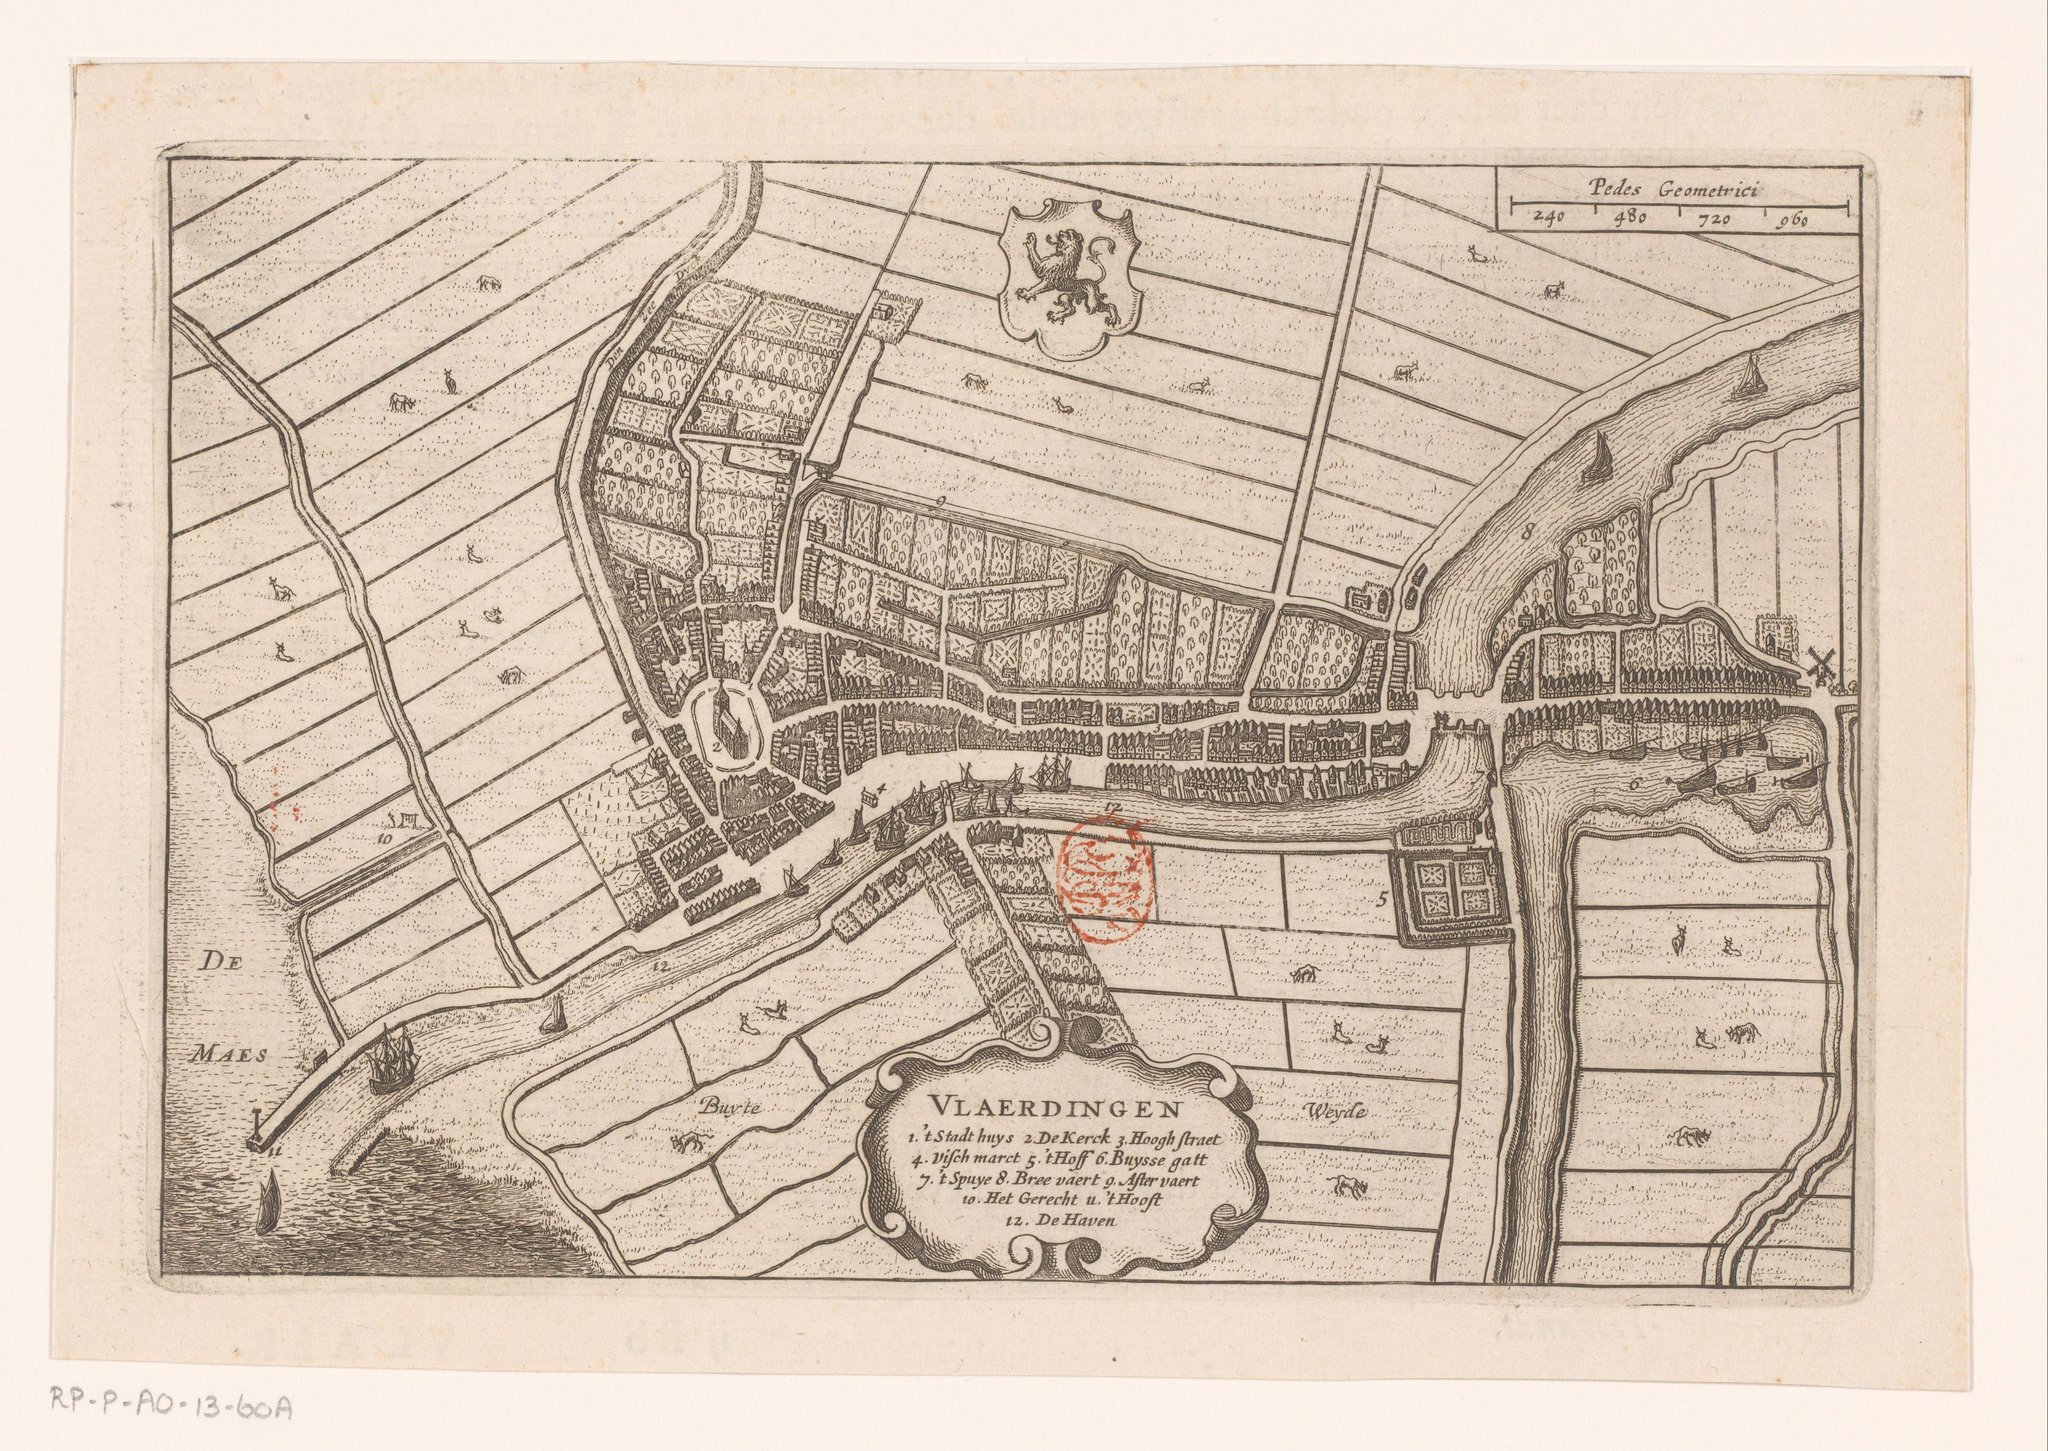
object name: print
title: Plattegrond van Vlaardingen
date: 1632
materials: paper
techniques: engraving, etching, letterpress printing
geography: amsterdam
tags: coat of arms (as symbol of the state, etc.) (+ city; municipal), maps of cities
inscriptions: collector's mark: Lugt 195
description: Prent gebruikt in: Blaeu, Johannes Willemszoon. Toonneel der steden van de Vereenighde Nederlanden. 2 delen. Amsterdam: Johannes Willemszoon Blaeu, 1652, dl. 1. Prent voor het eerst ook gebruikt in: Boxhorn, Marcus Zuerius van. Theatrum sive Hollandiae comitatus et urbium nova descriptio (…). Amsterdam: Henricus Hondius, 1632.